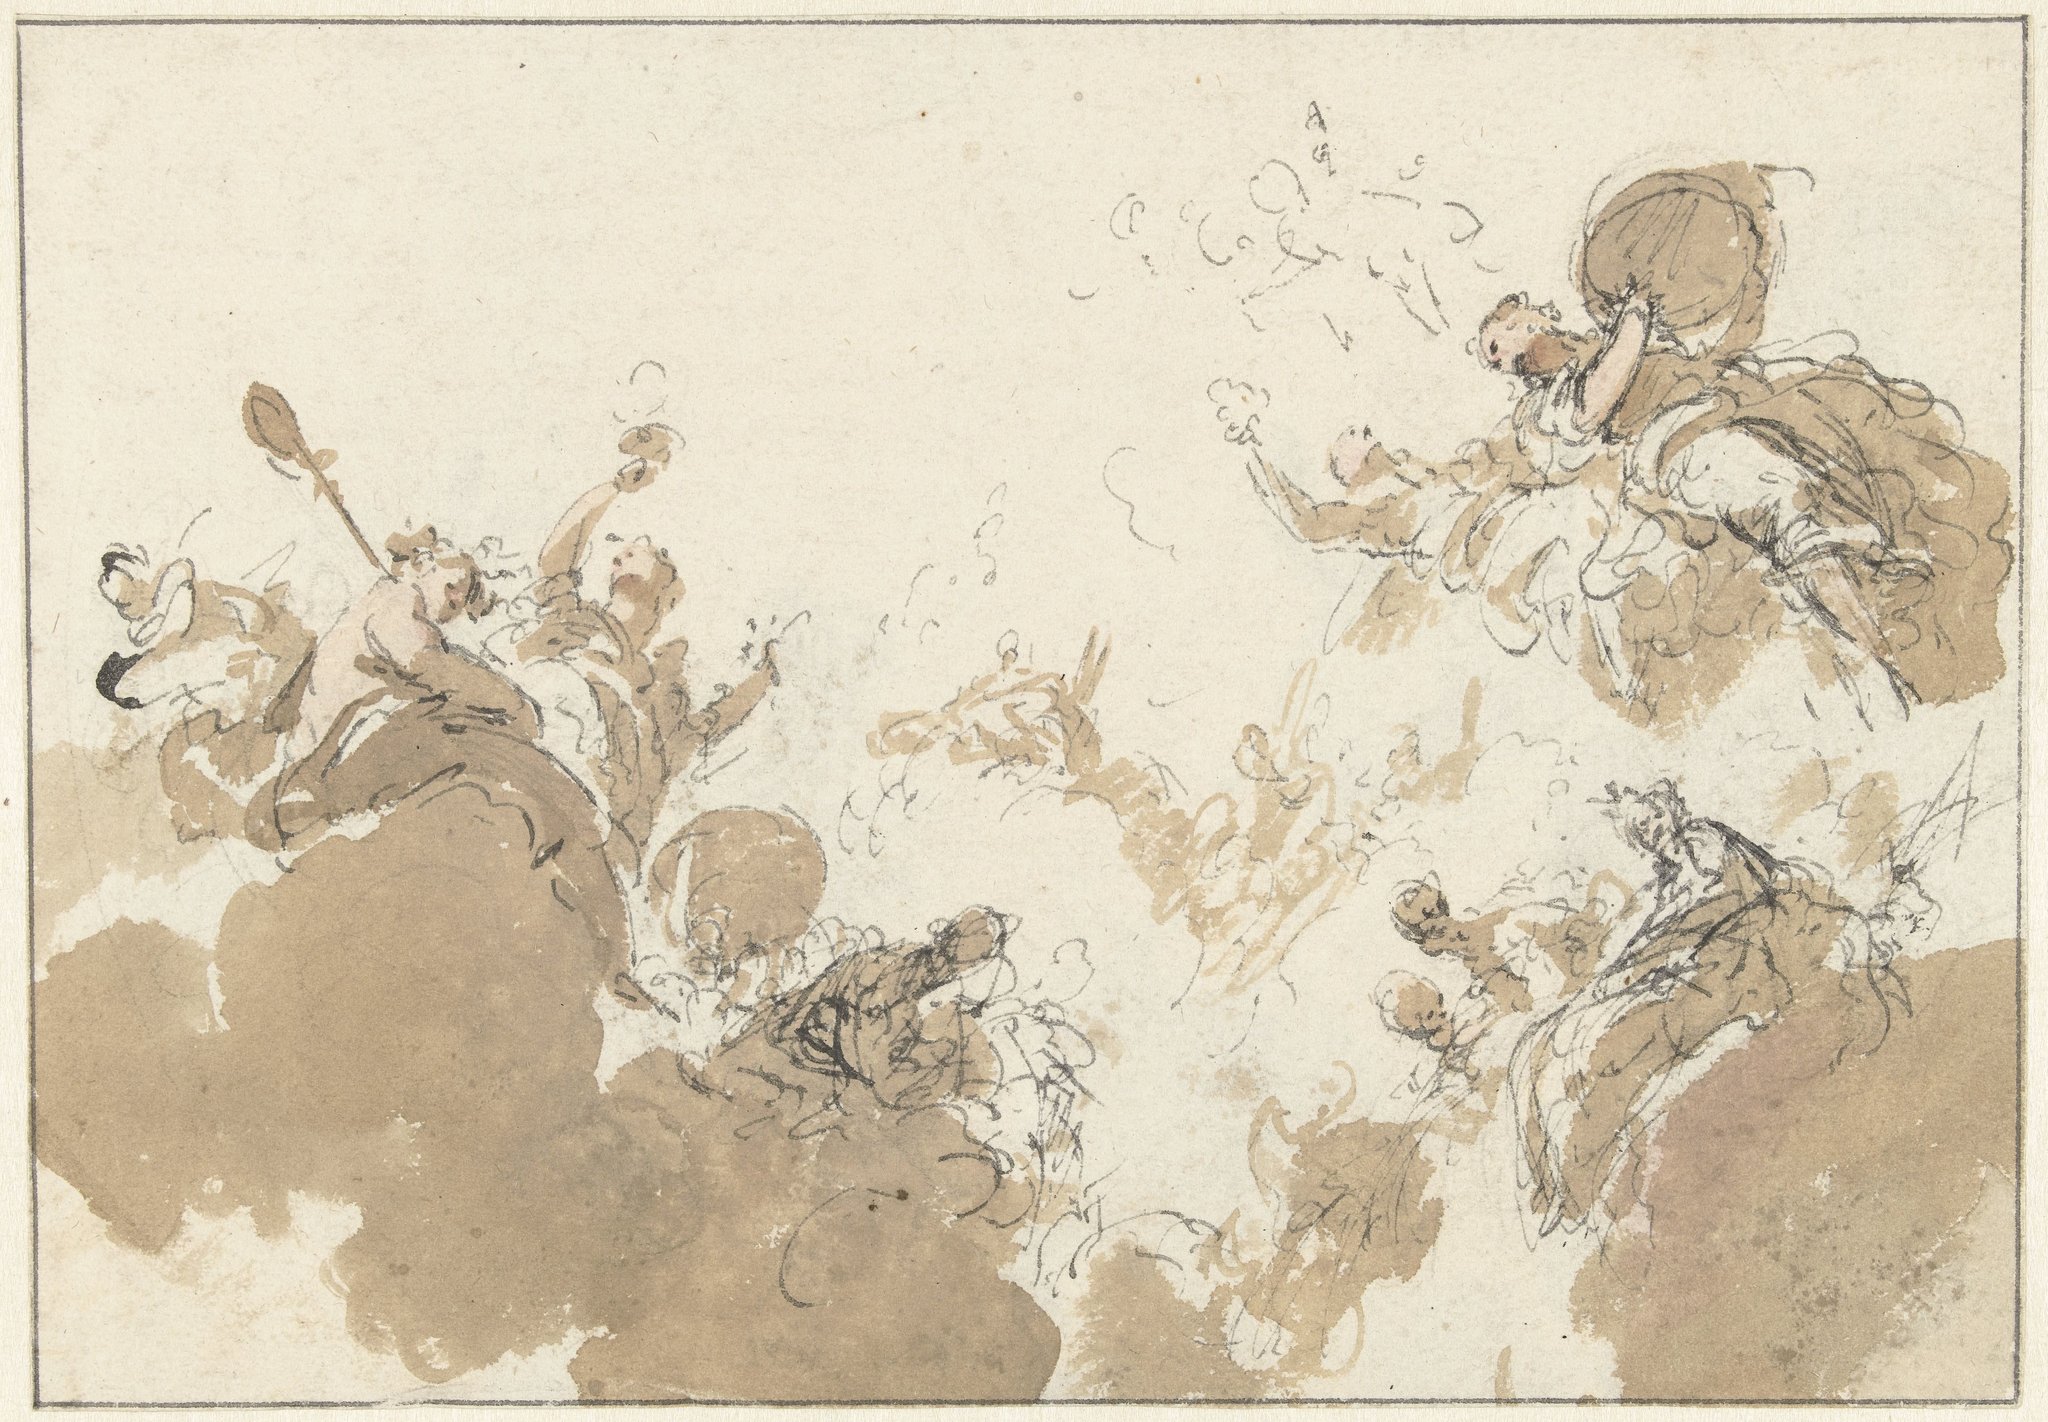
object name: design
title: Ontwerp voor plafondschildering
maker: jacob de wit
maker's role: draughtsman, painter, print maker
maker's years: 1695-1754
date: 1705-1754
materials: ink, paper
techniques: brush, pen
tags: sitting or standing on clouds